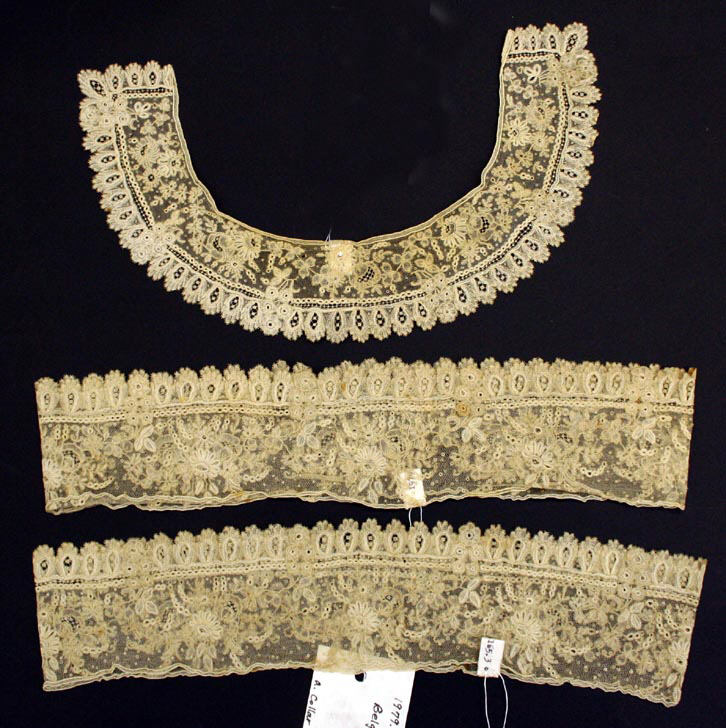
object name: accessory set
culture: belgian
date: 1851-1875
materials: cotton